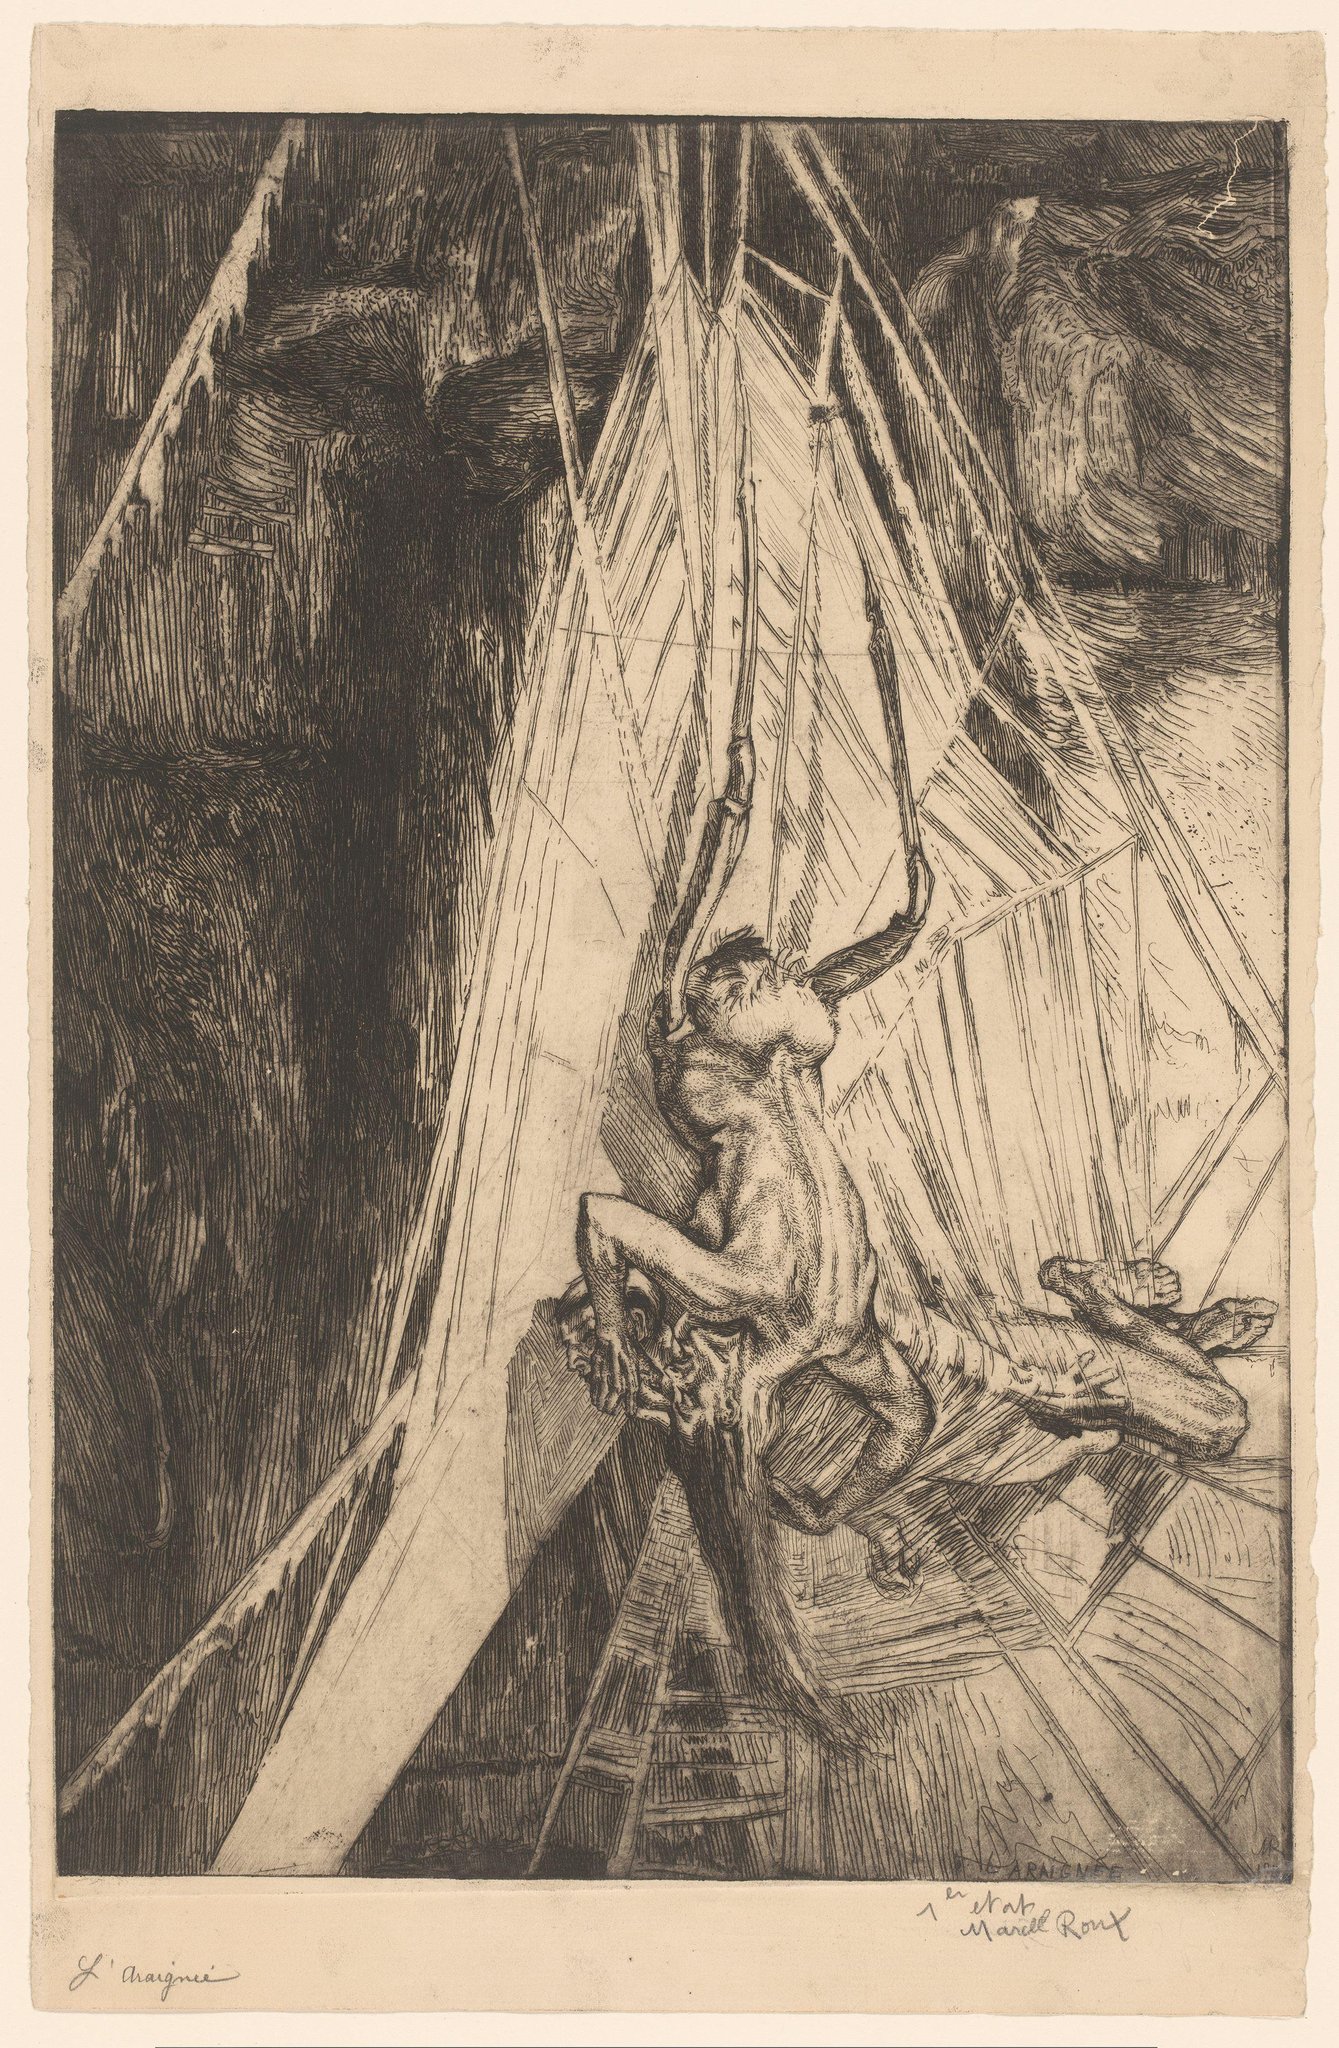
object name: print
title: Spinnenweb met mensachtige spin die een man gevangen heeft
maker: marcel roux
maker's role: print maker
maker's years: 1878-1922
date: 1910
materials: paper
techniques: drypoint, etching, intaglio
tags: (corpse of) man eaten by animals, spiders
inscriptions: collector's mark: Lugt 2113, collector's mark: Lugt 2228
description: Wezen met het onderlijf van een spin en het bovenlijf van een vrouw buigt zich over het lichaam van een man.